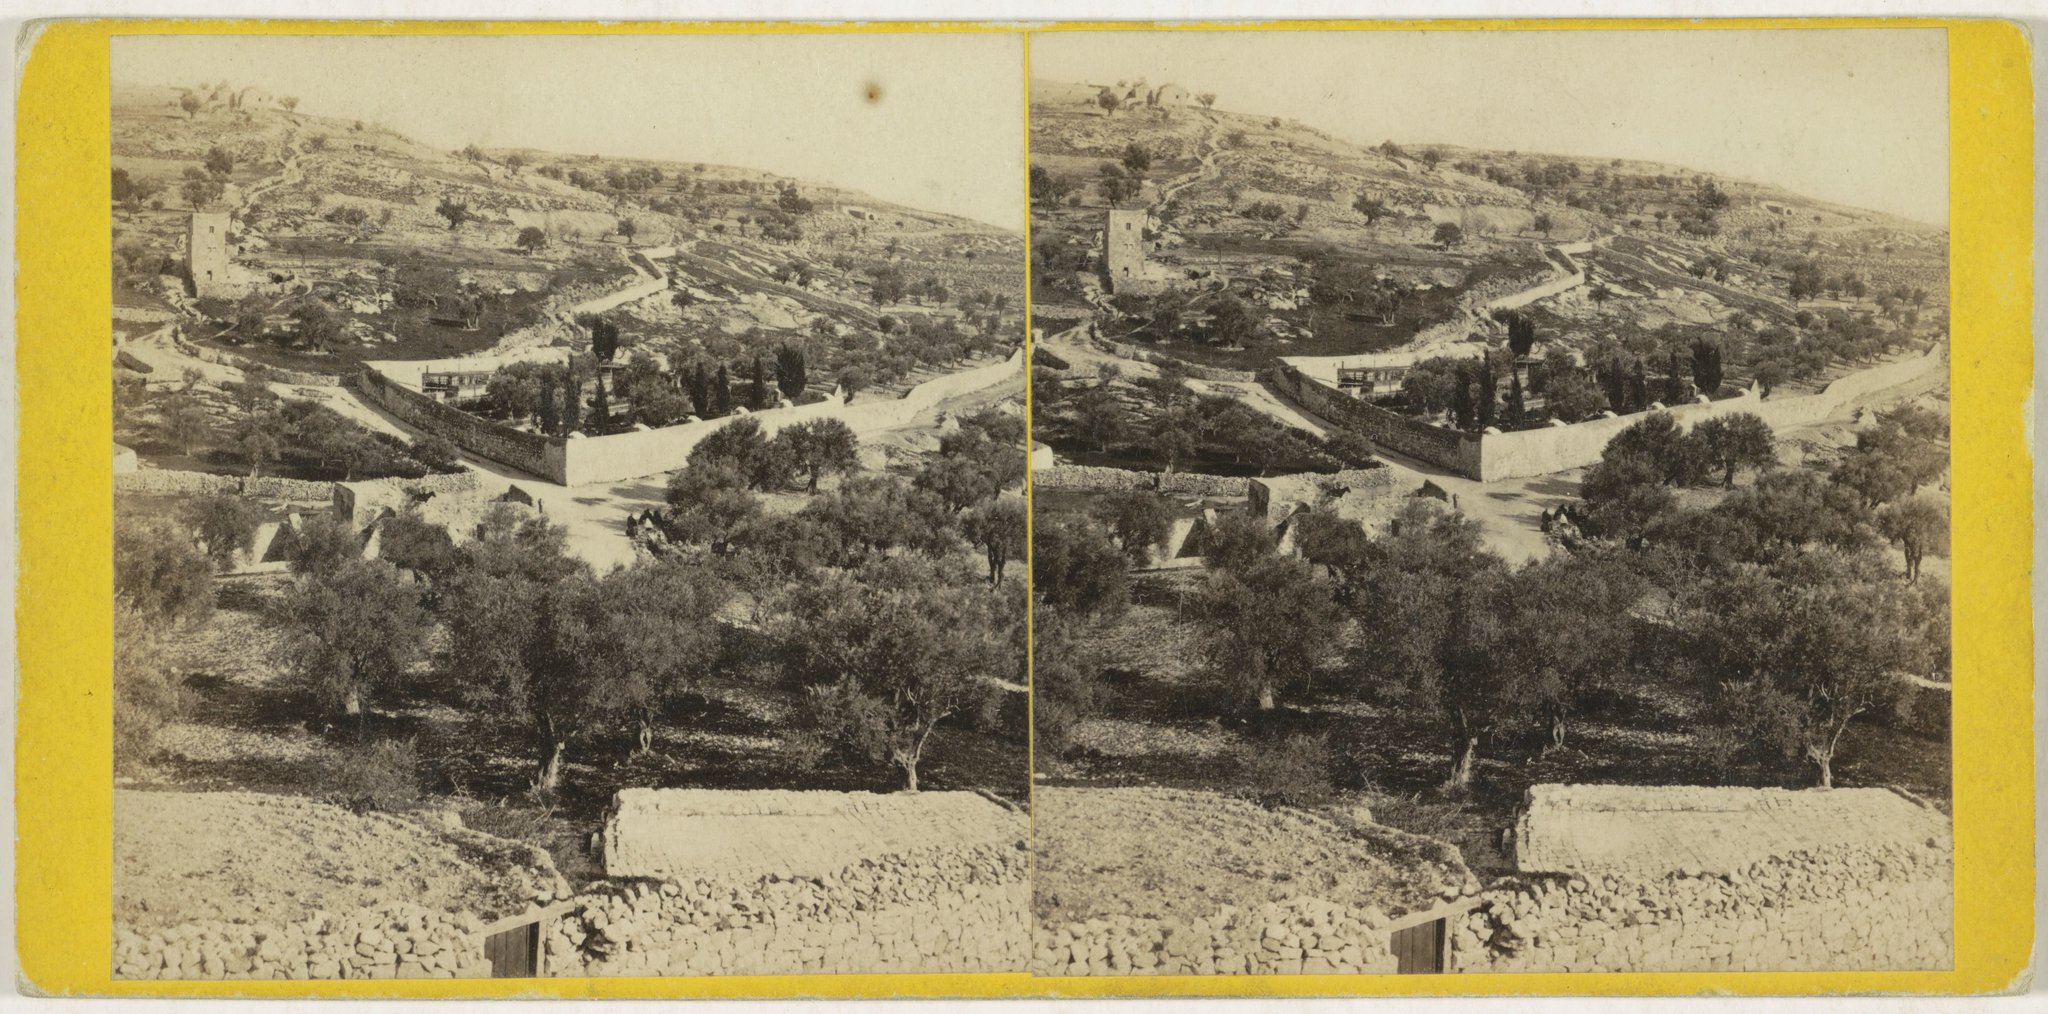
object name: stereograph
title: Jerusalem. - The Mount of Olives, and c. / Jérusalem. - La Montagne des Olives, &c.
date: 1860-1880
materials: cardboard, paper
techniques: albumen print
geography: olijfberg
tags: (high) hill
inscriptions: number: ‘No. 256.’